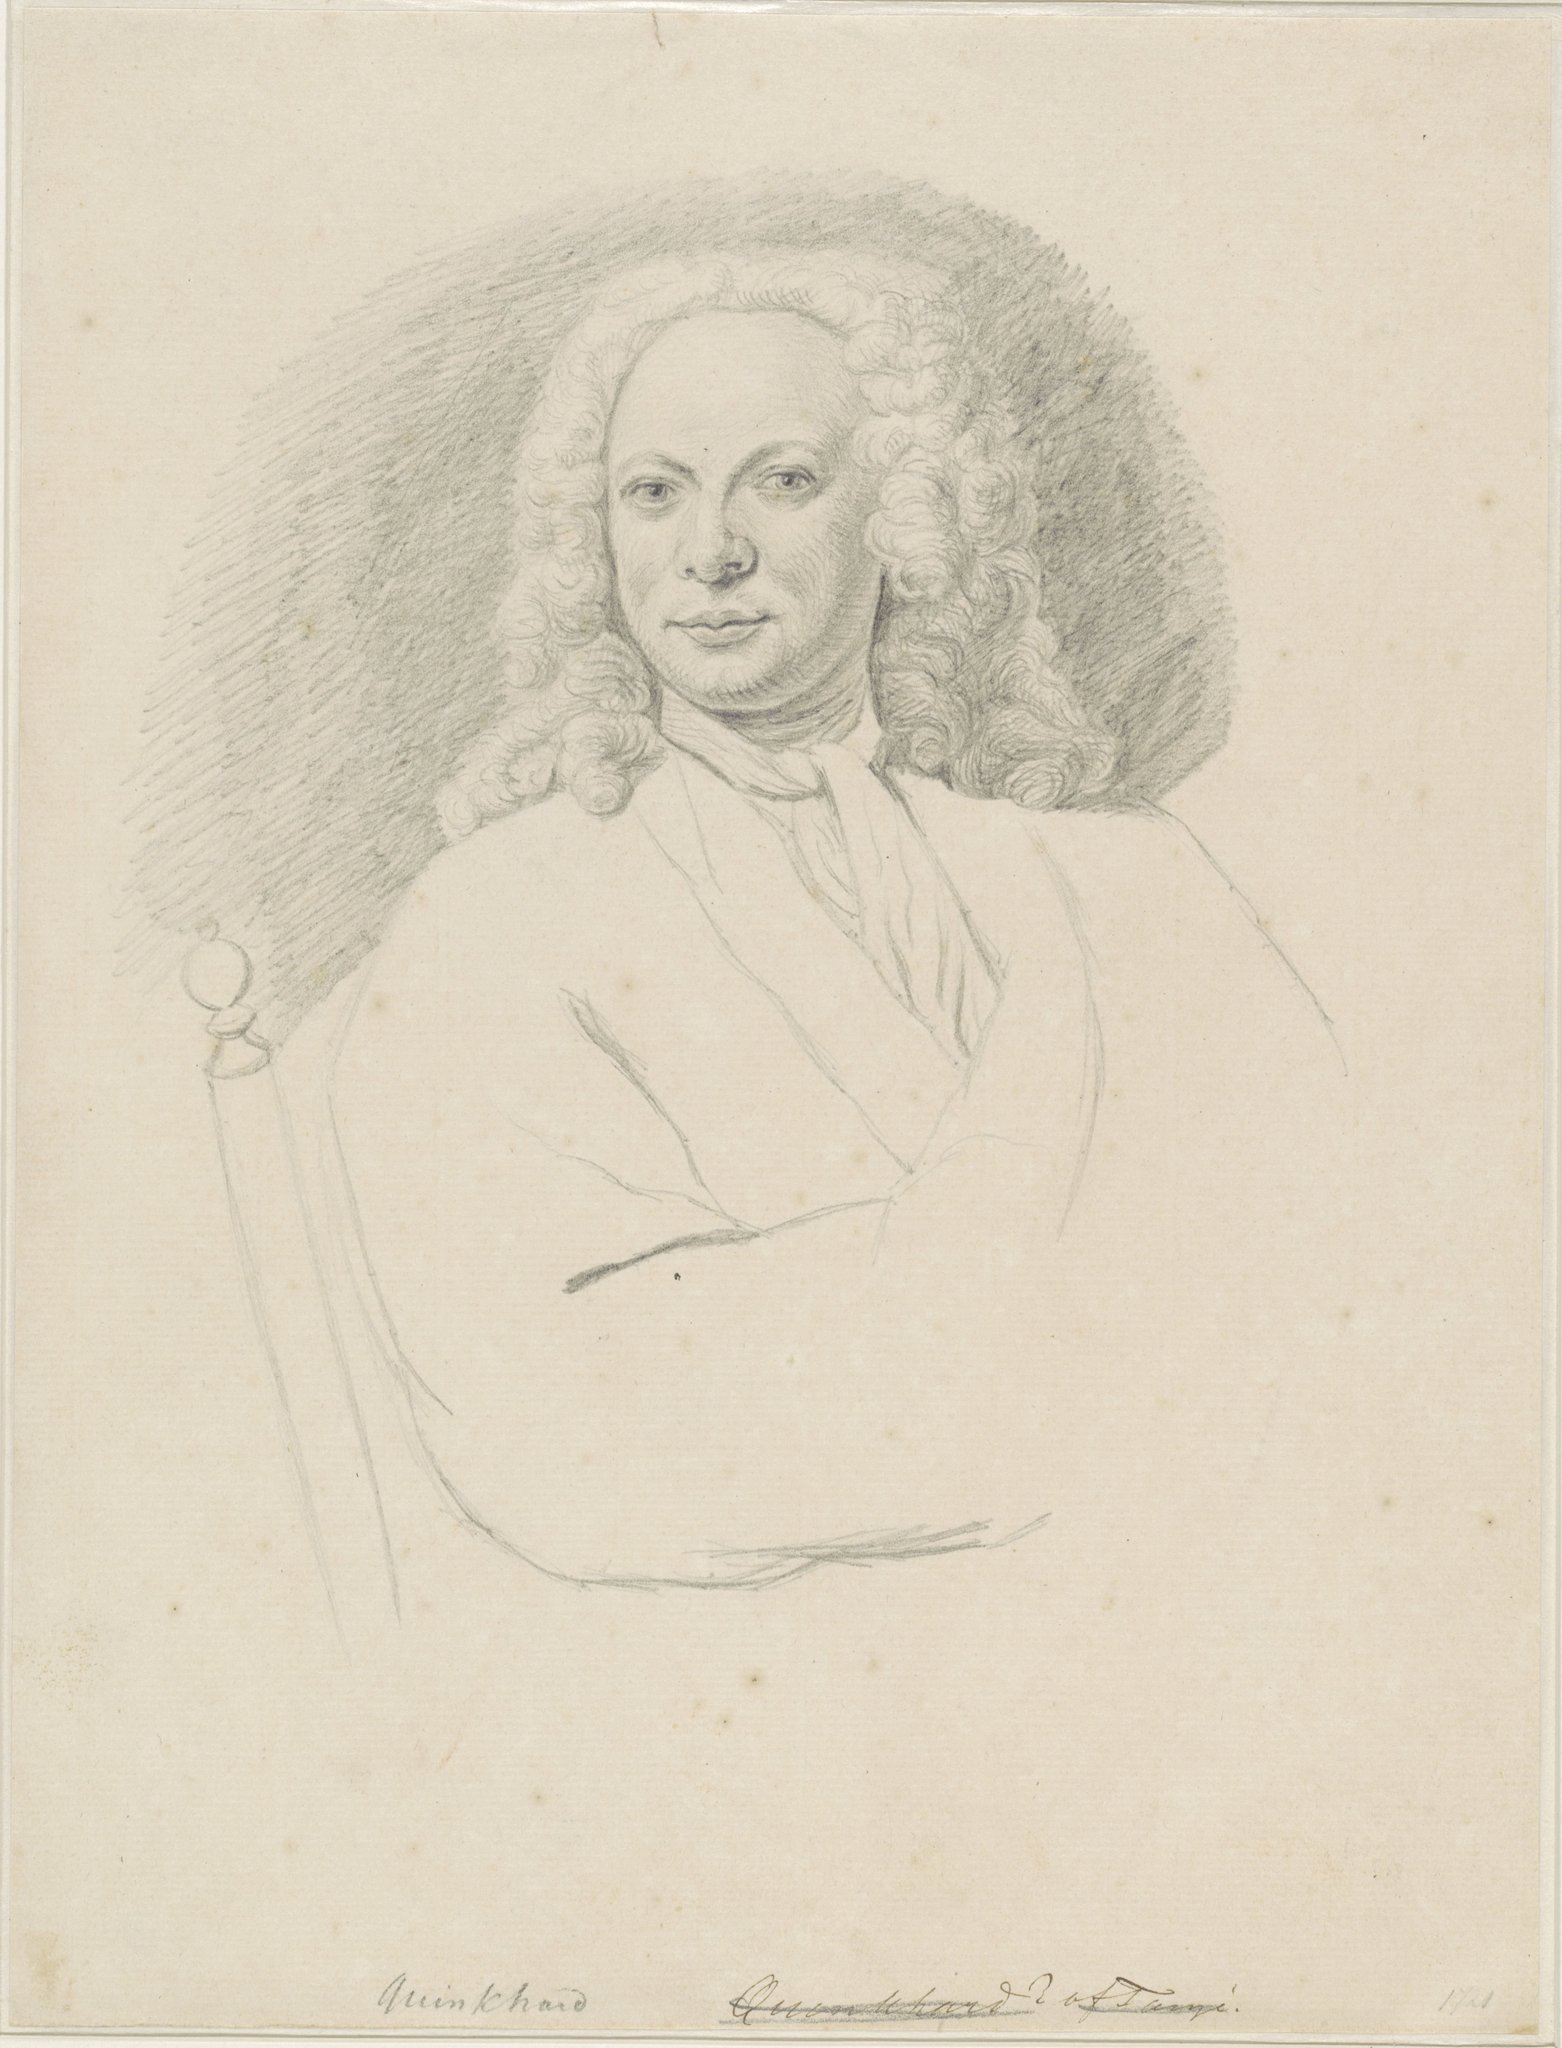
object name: drawing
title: Portret van Jan Maurits Quinkhard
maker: Anonymous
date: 1698-1822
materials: paper, pencil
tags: draughtsman, jan maurits quinkhard, historical persons, portrait, self-portrait of artist